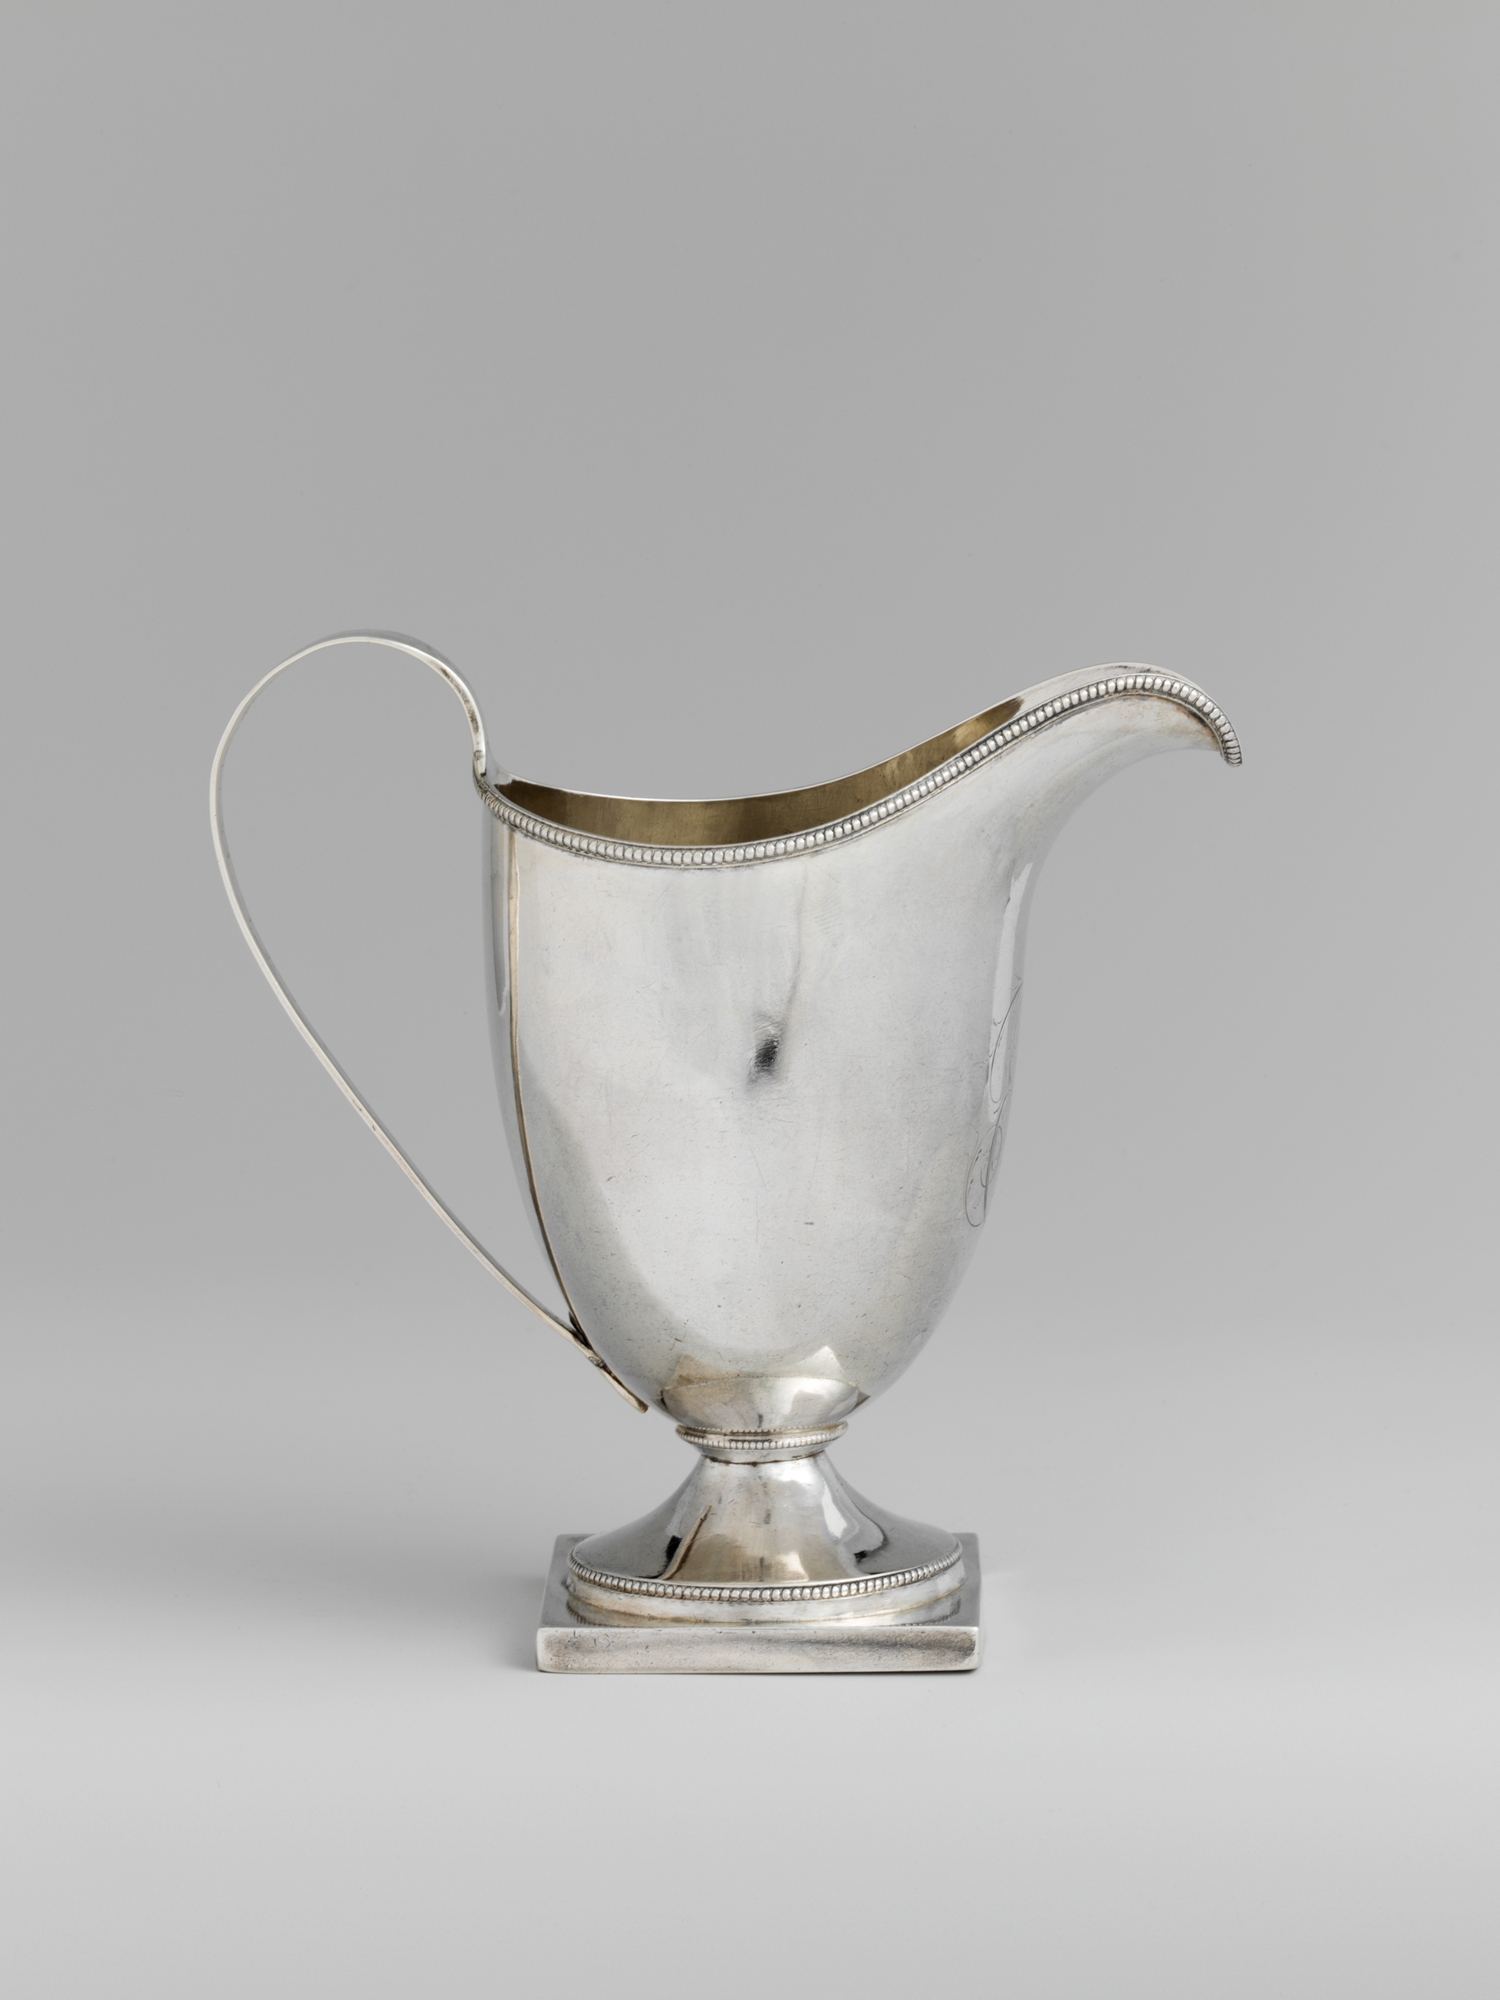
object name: cream pot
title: Creamer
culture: american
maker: hugh wishart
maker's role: maker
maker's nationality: american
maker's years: 1793-1824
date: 1800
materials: silver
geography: united states